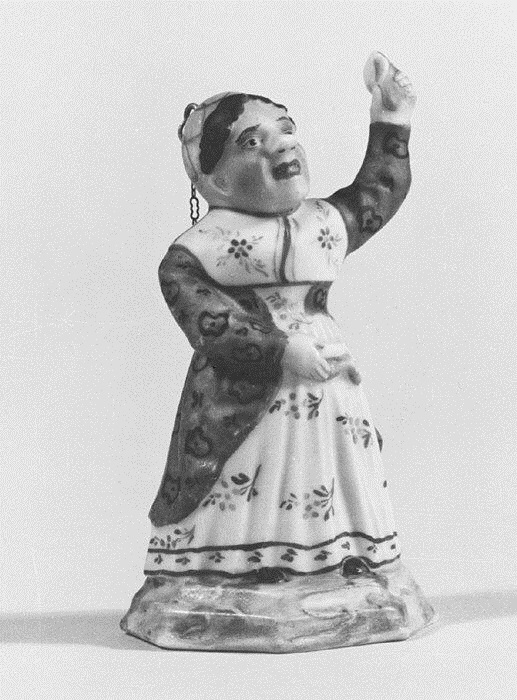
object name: scent flask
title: Peasant woman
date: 1801-1900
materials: hard paste porcelain, silver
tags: women